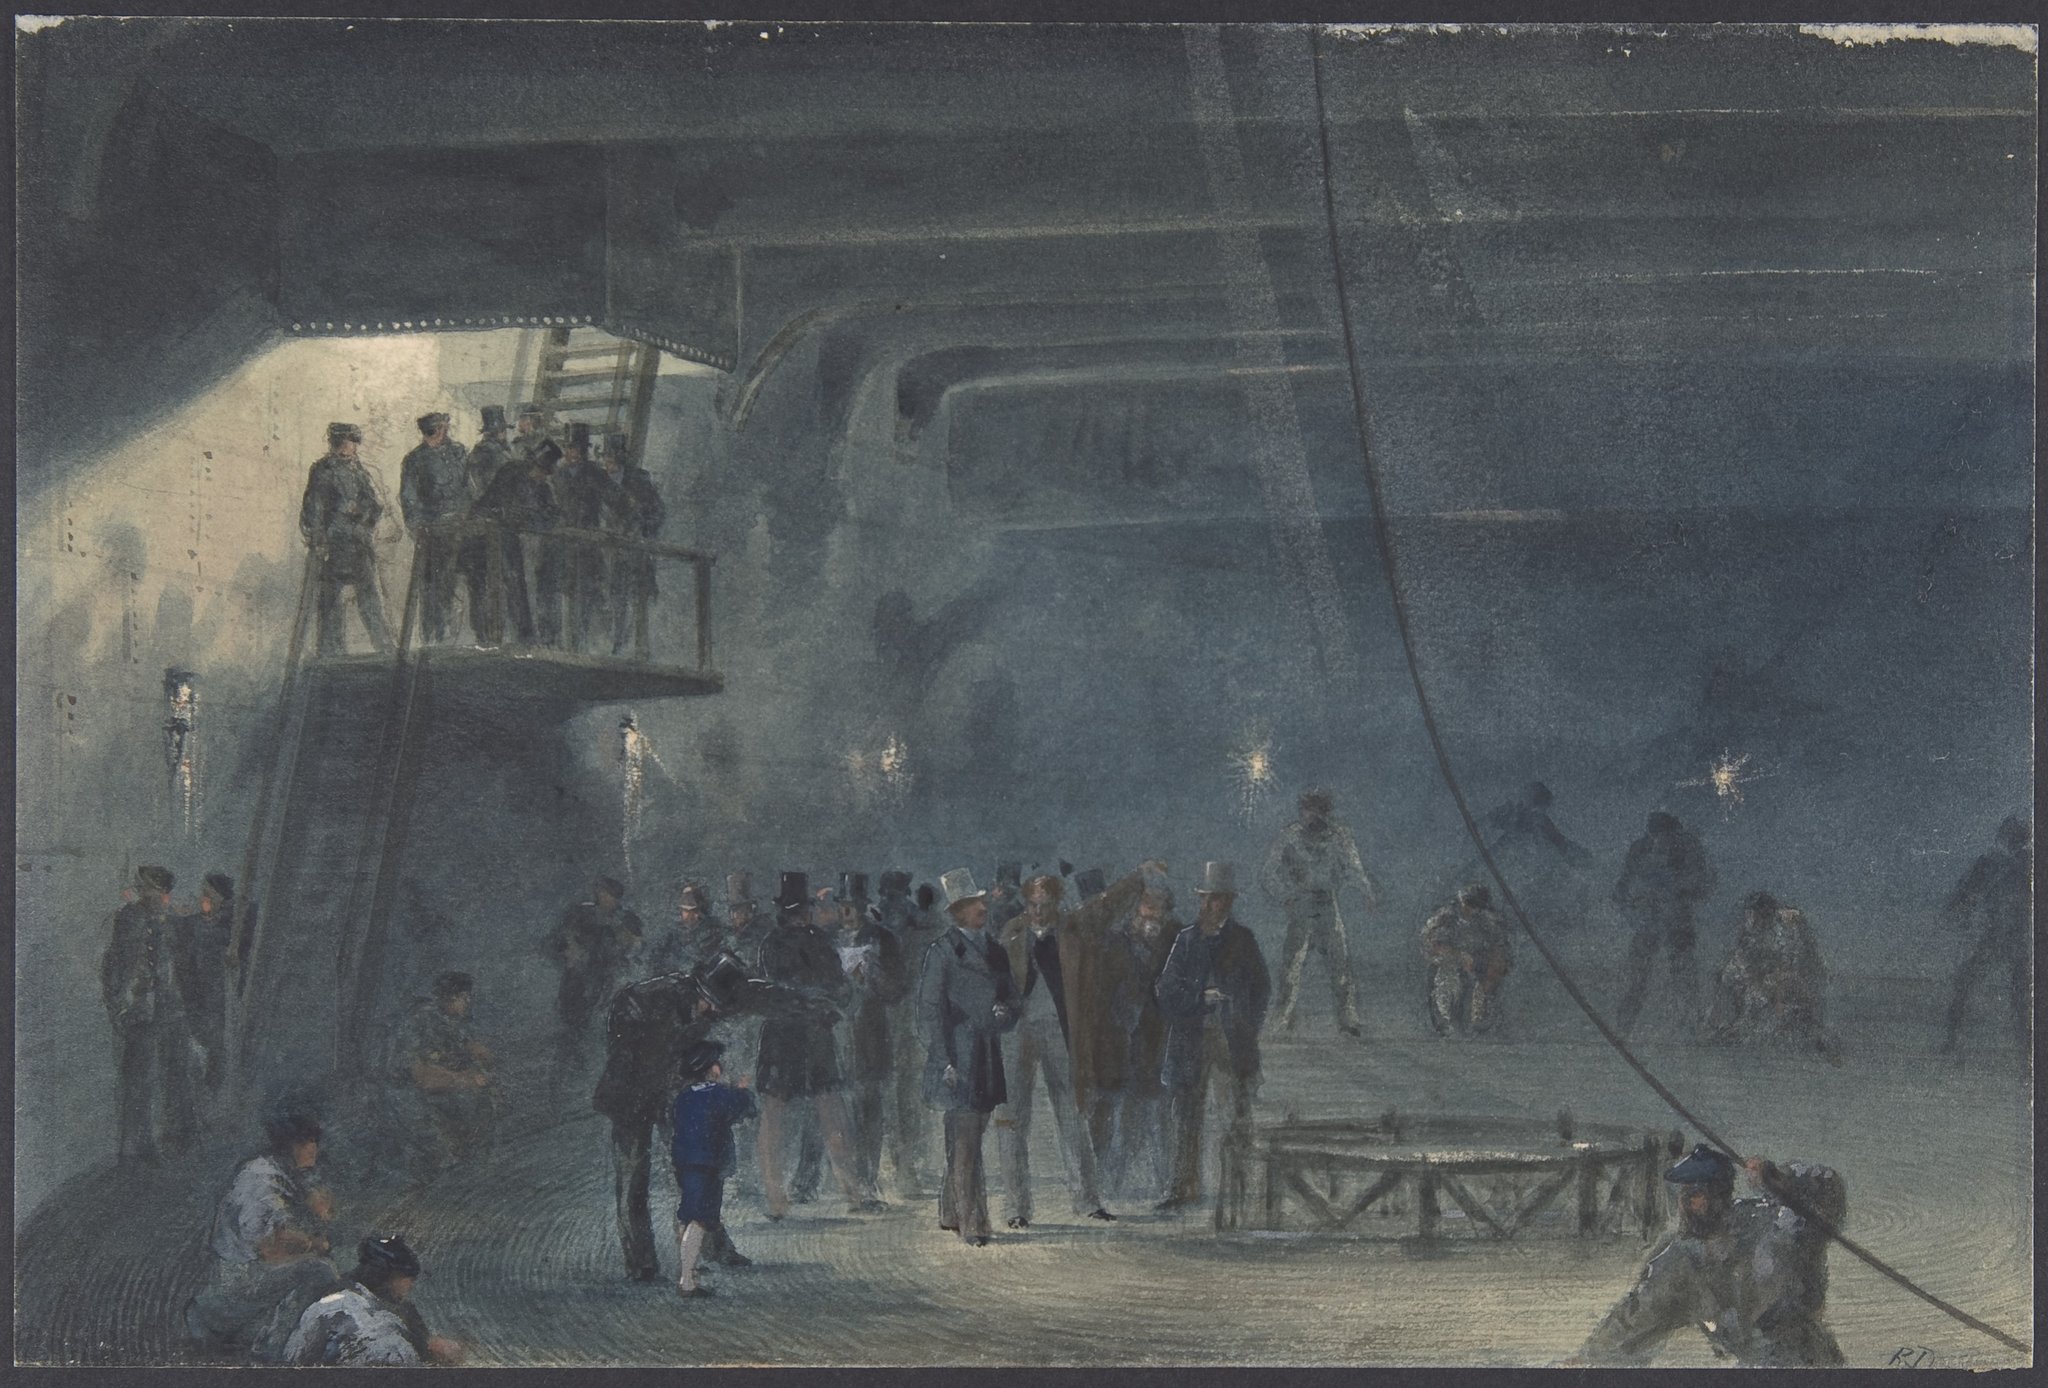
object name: drawing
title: Coiling the Cable in the After-tank on Board the Great Eastern at Sheerness: Visit of H.R.H. the Prince of Wales on May 23rd, 1865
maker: robert charles dudley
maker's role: artist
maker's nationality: british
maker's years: 1826-1909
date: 1865-1866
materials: gouache, graphite, watercolor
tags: men,working,industry,transatlantic cable